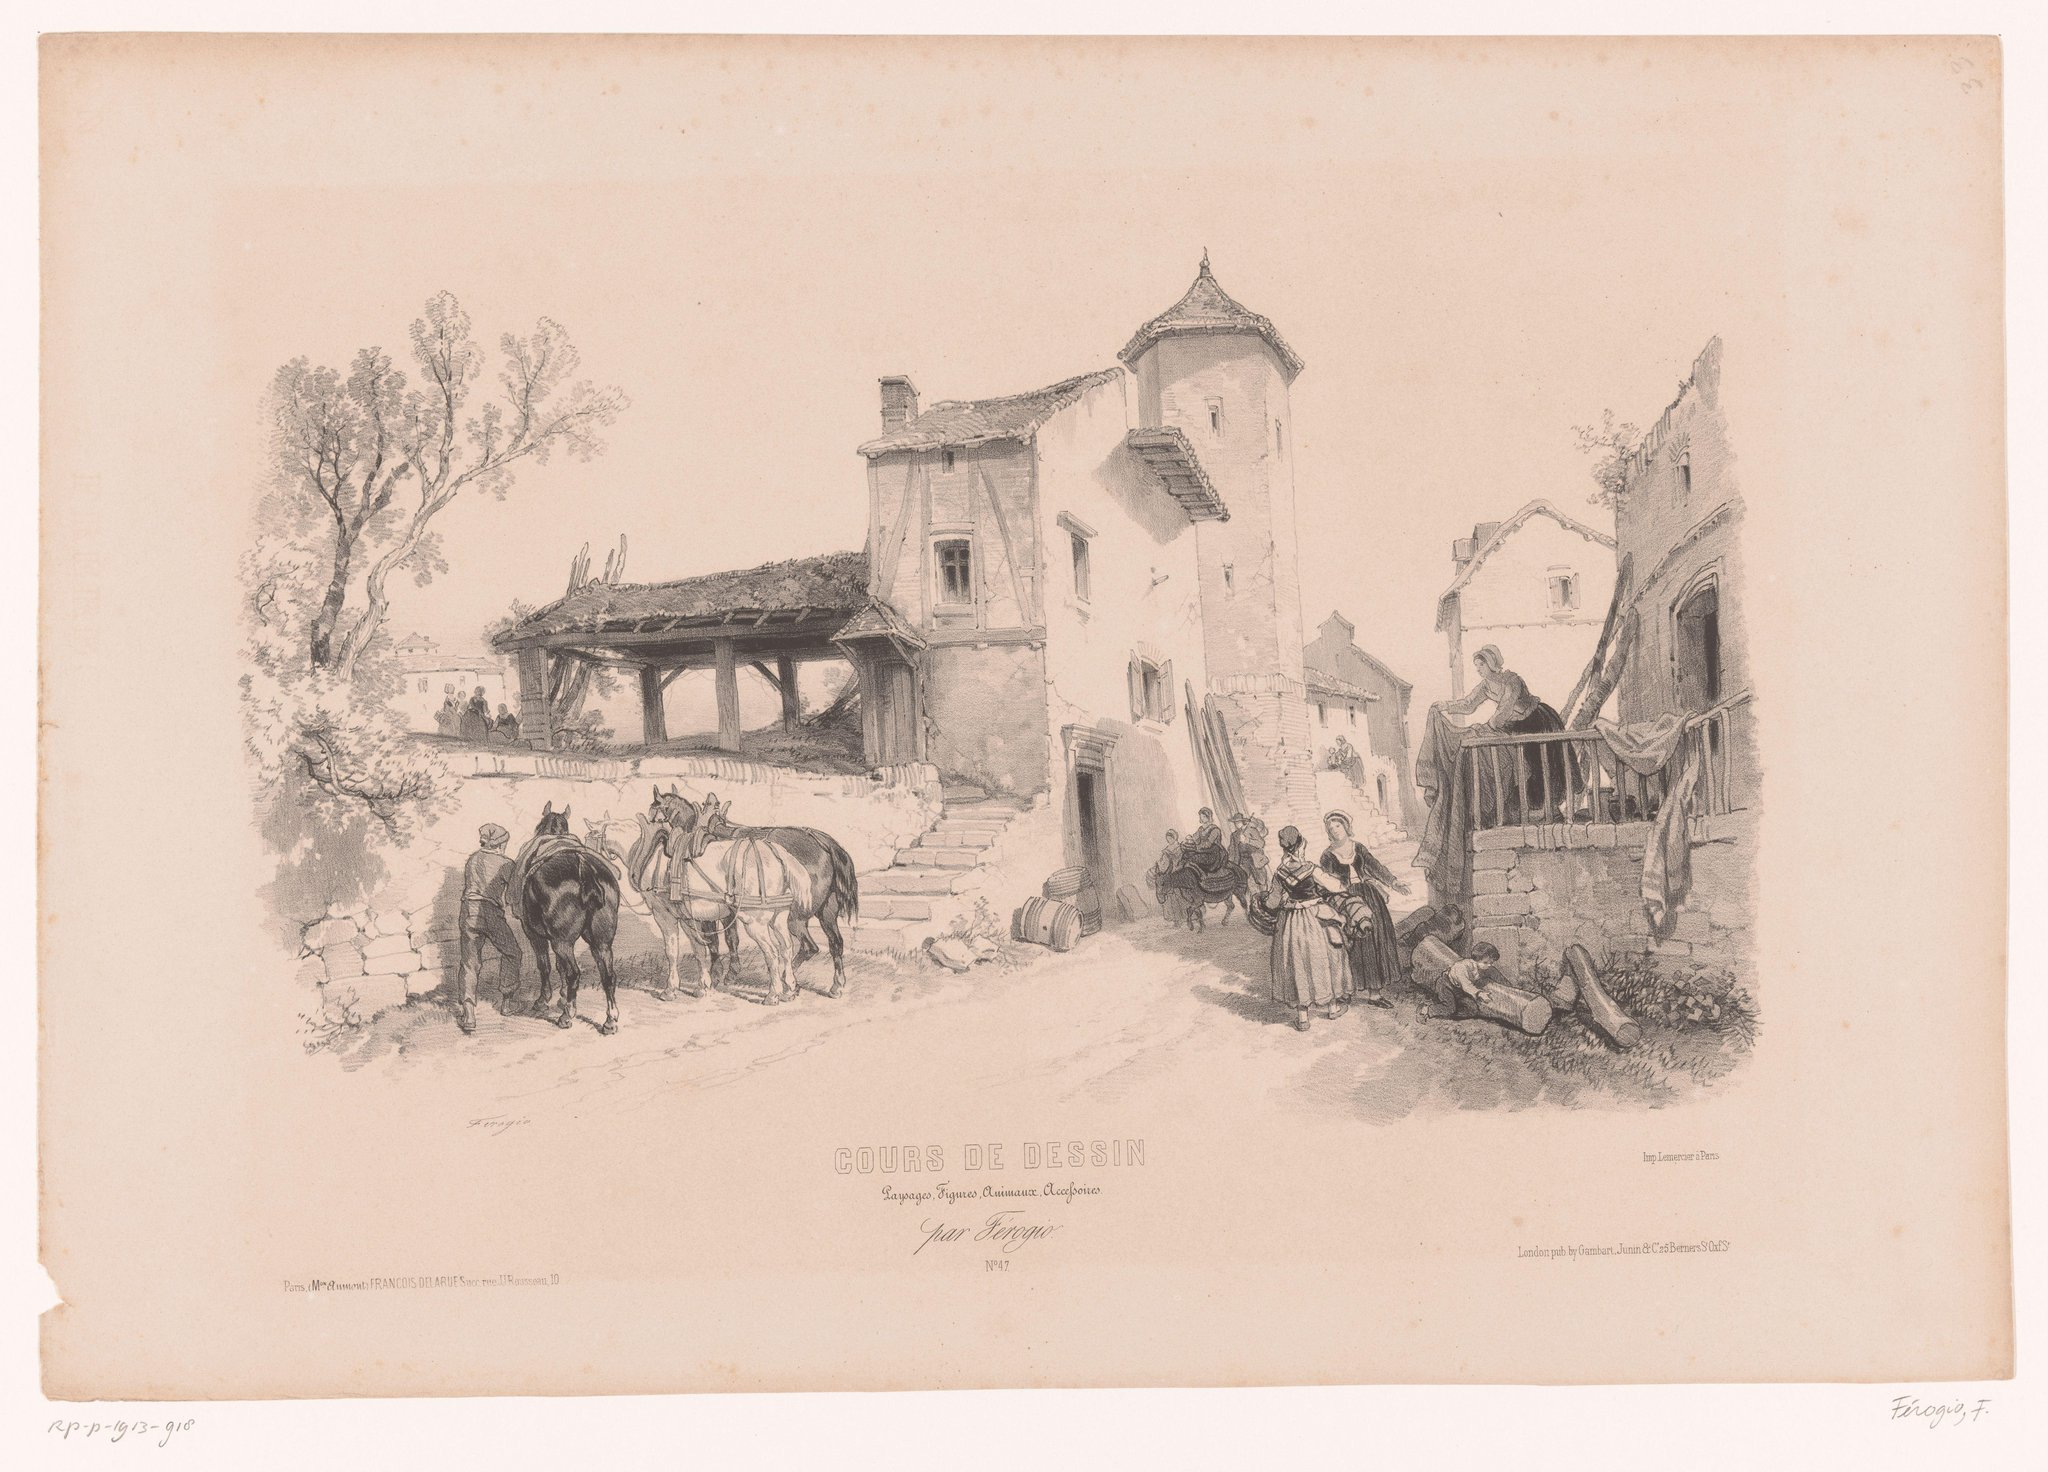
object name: print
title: Dorpsstraat met paarden en diverse figuren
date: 1845-1846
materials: paper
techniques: lithograph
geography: paris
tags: country dwellers, village street, civic architecture; edifices; dwellings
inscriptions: collector's mark: Lugt 2228a